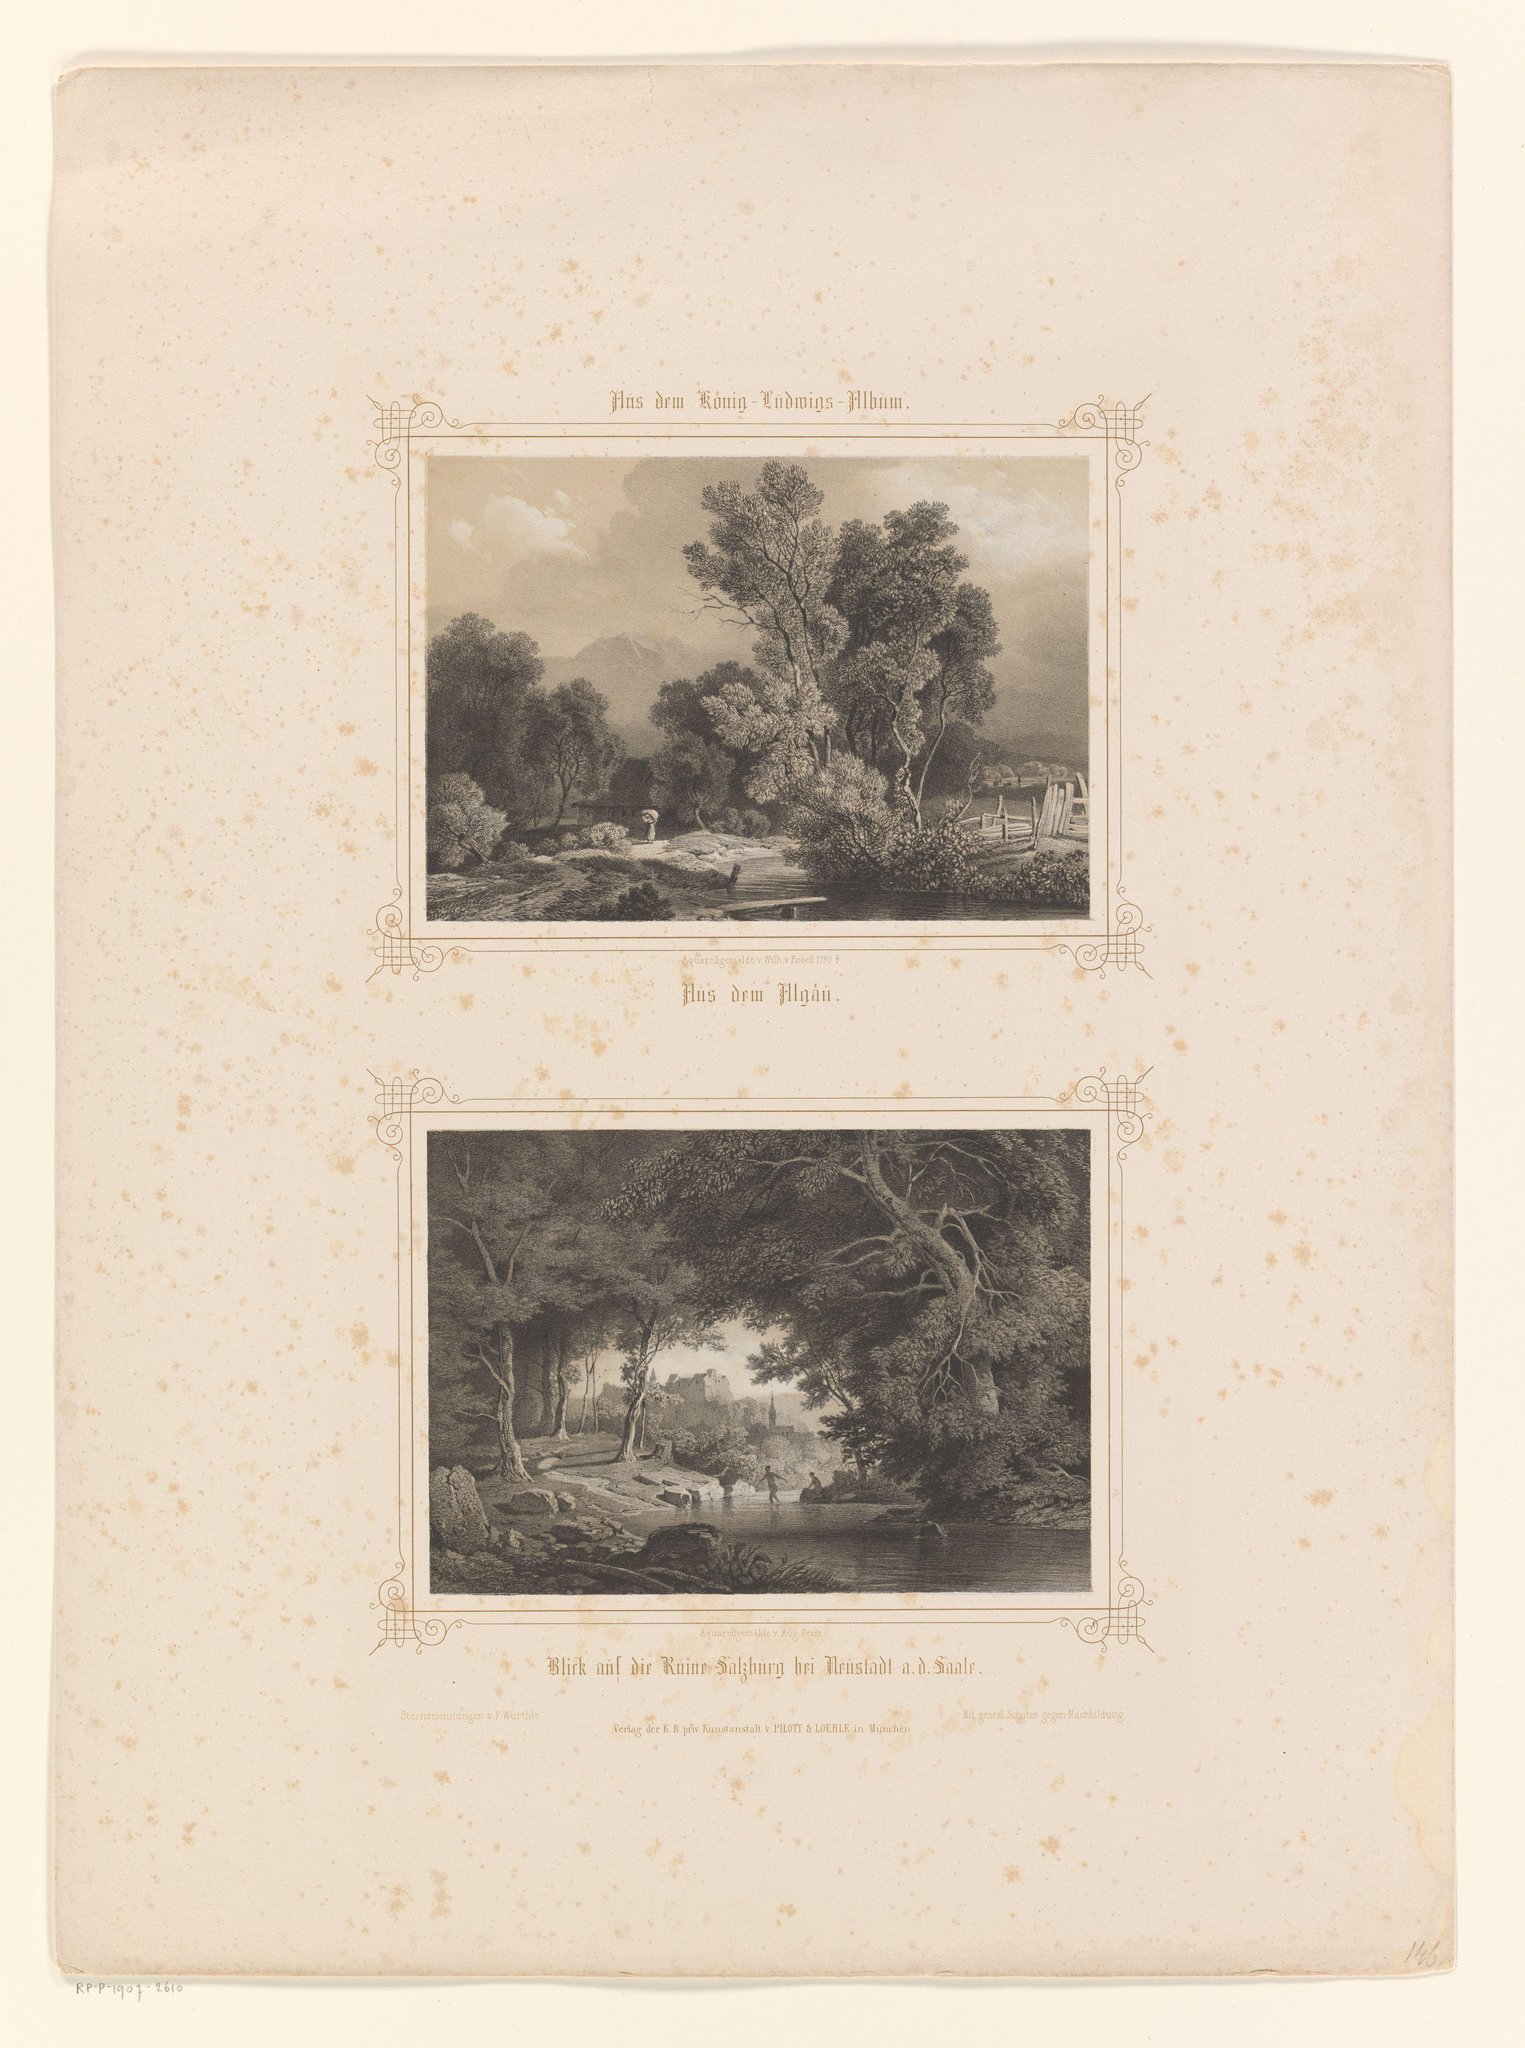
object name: print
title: Blick auf die Ruine Salzburg bei Neustadt a.d. Saale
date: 1850-1859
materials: paper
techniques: tone lithography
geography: munich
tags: water course, landscapes in the temperate zone (+ landscape with figures, staffage), landscape with ruins - ii - ideal landscapes, germany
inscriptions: collector's mark: Lugt 2228, check stamp: ‘Piloty&Loehle, München’, : ‘Mit gesetzl Schutze gegen Nachbildung’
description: Prent afkomstig uit de serie 'Album Seiner Majestät des Königs Ludwig I. von Bayern', verschenen in verschillende afleveringen. De prenten gaan terug op het album dat Lodewijk I van Beieren op 9 oktober 1850 kreeg overhandigd van verschillende kunstenaars.